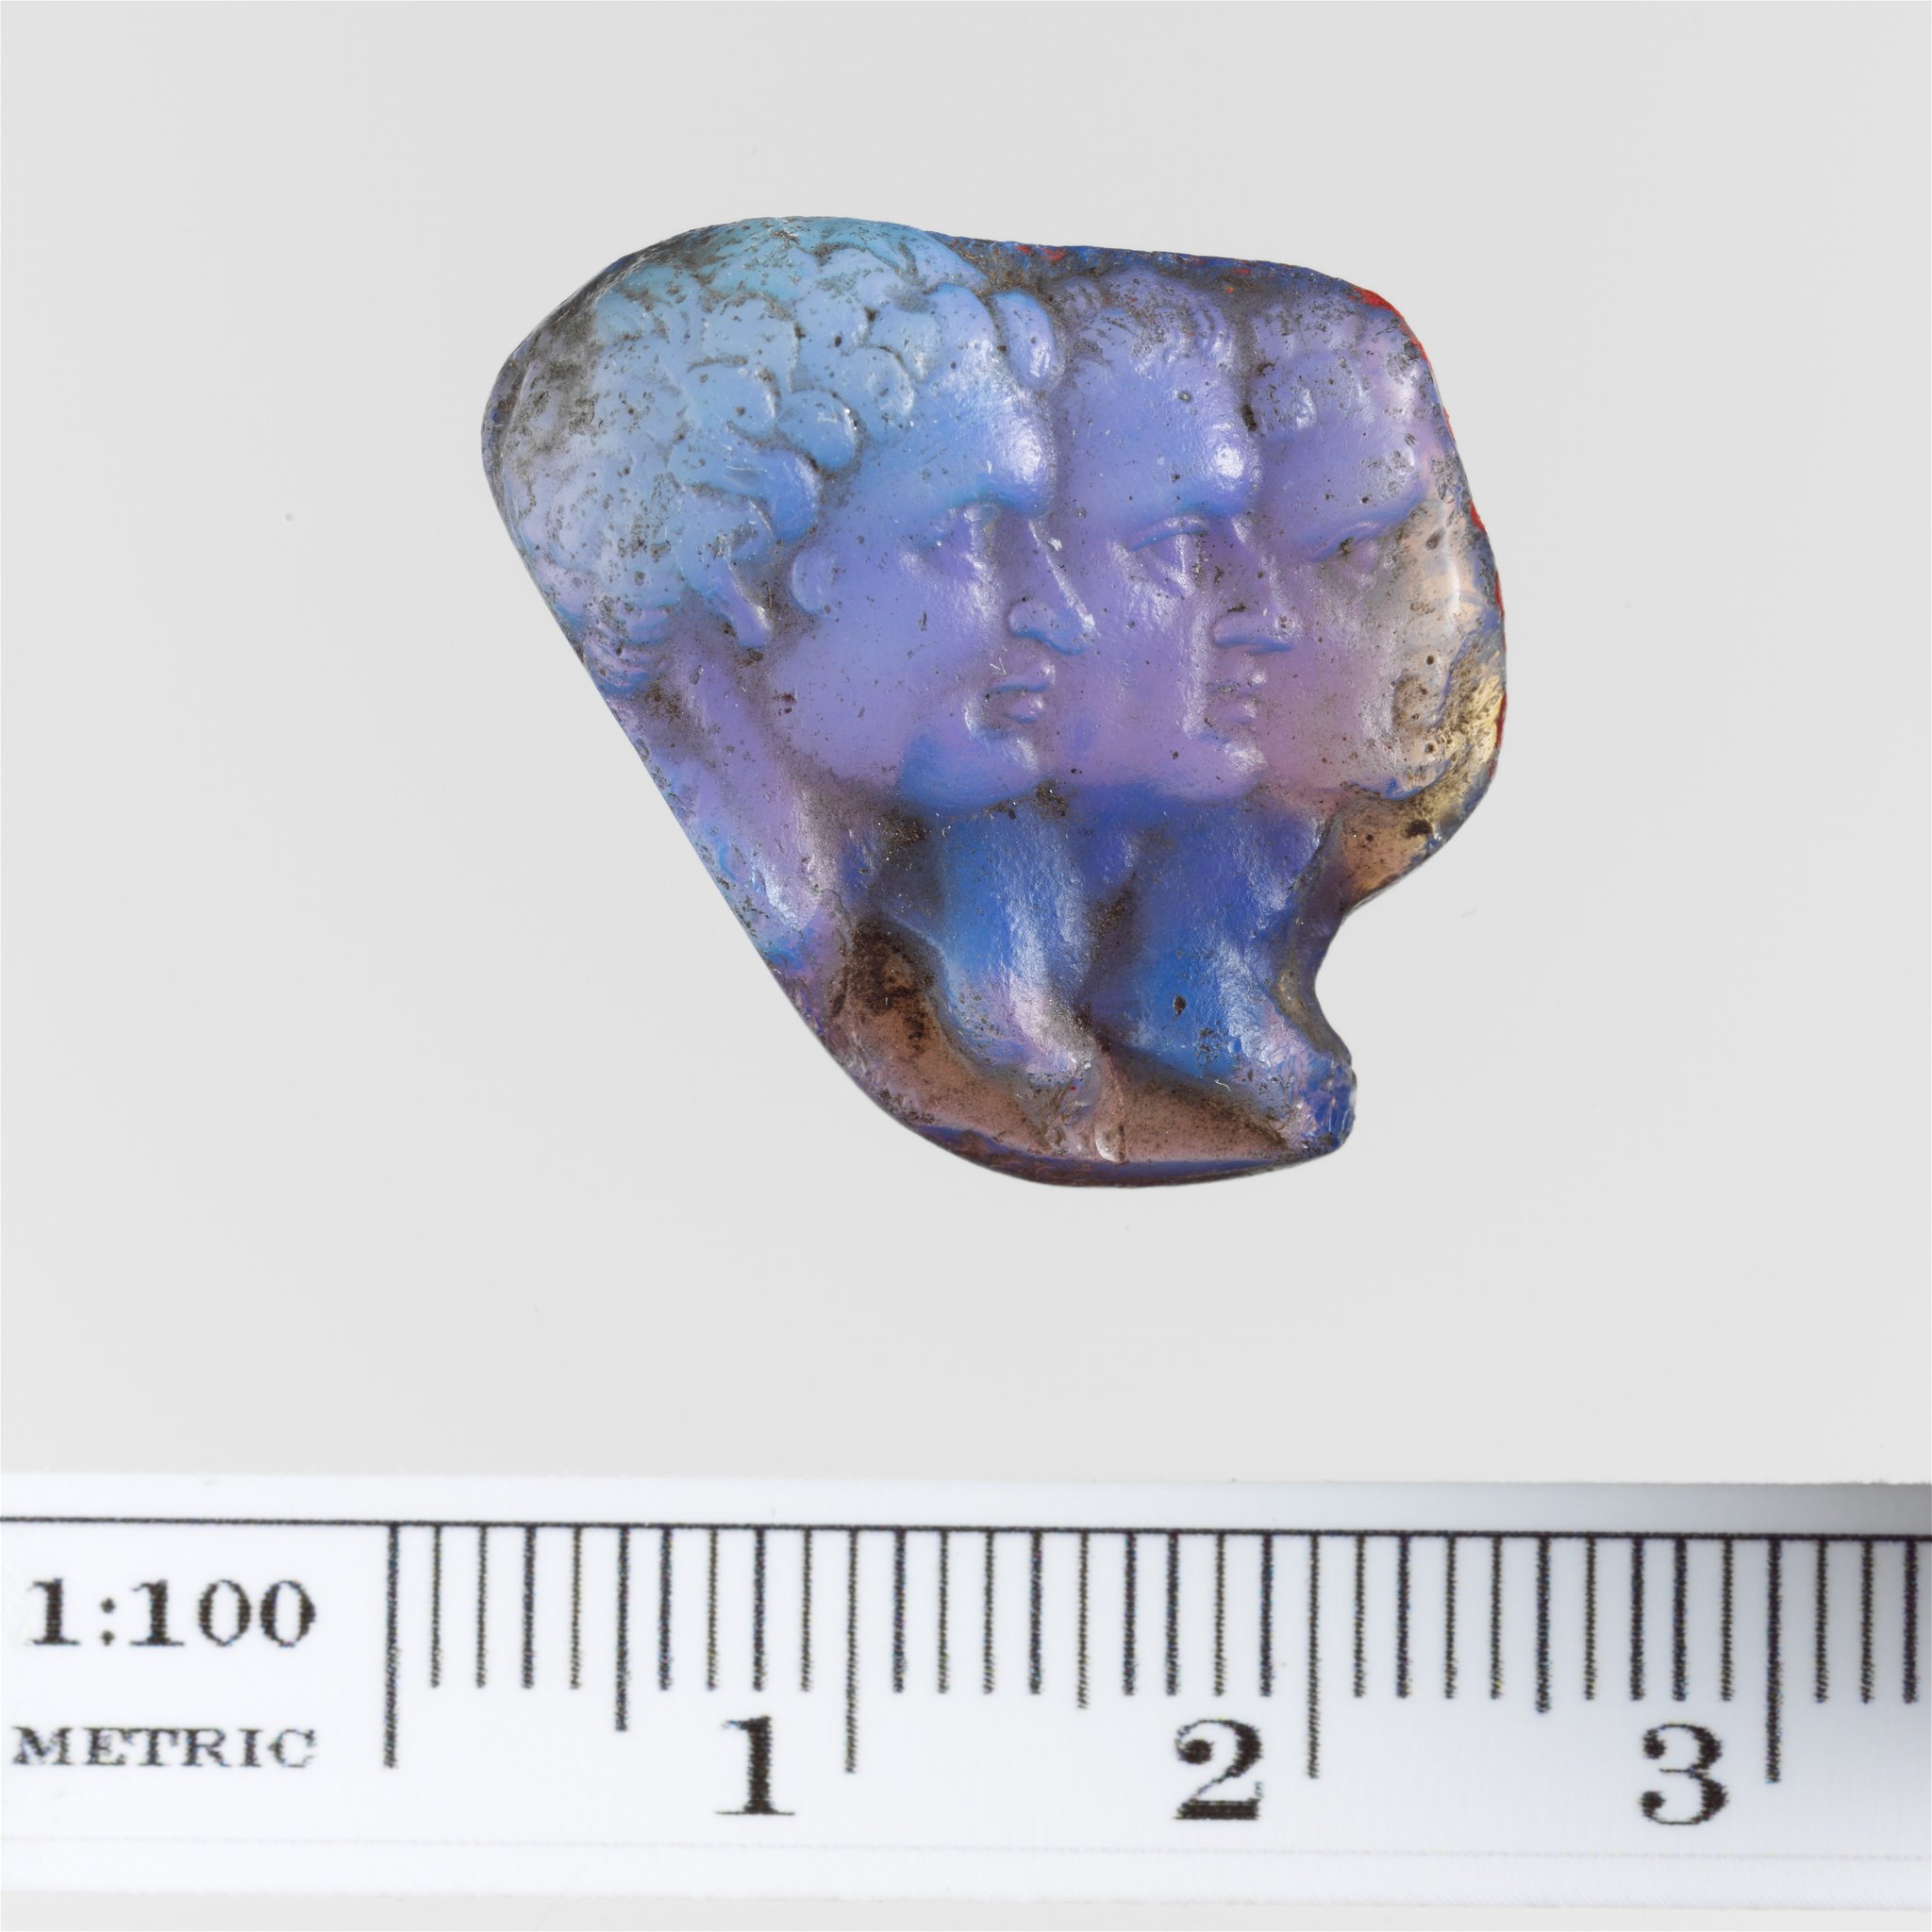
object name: cameo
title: Cameo glass with three portrait heads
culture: roman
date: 1-200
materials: glass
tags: heads